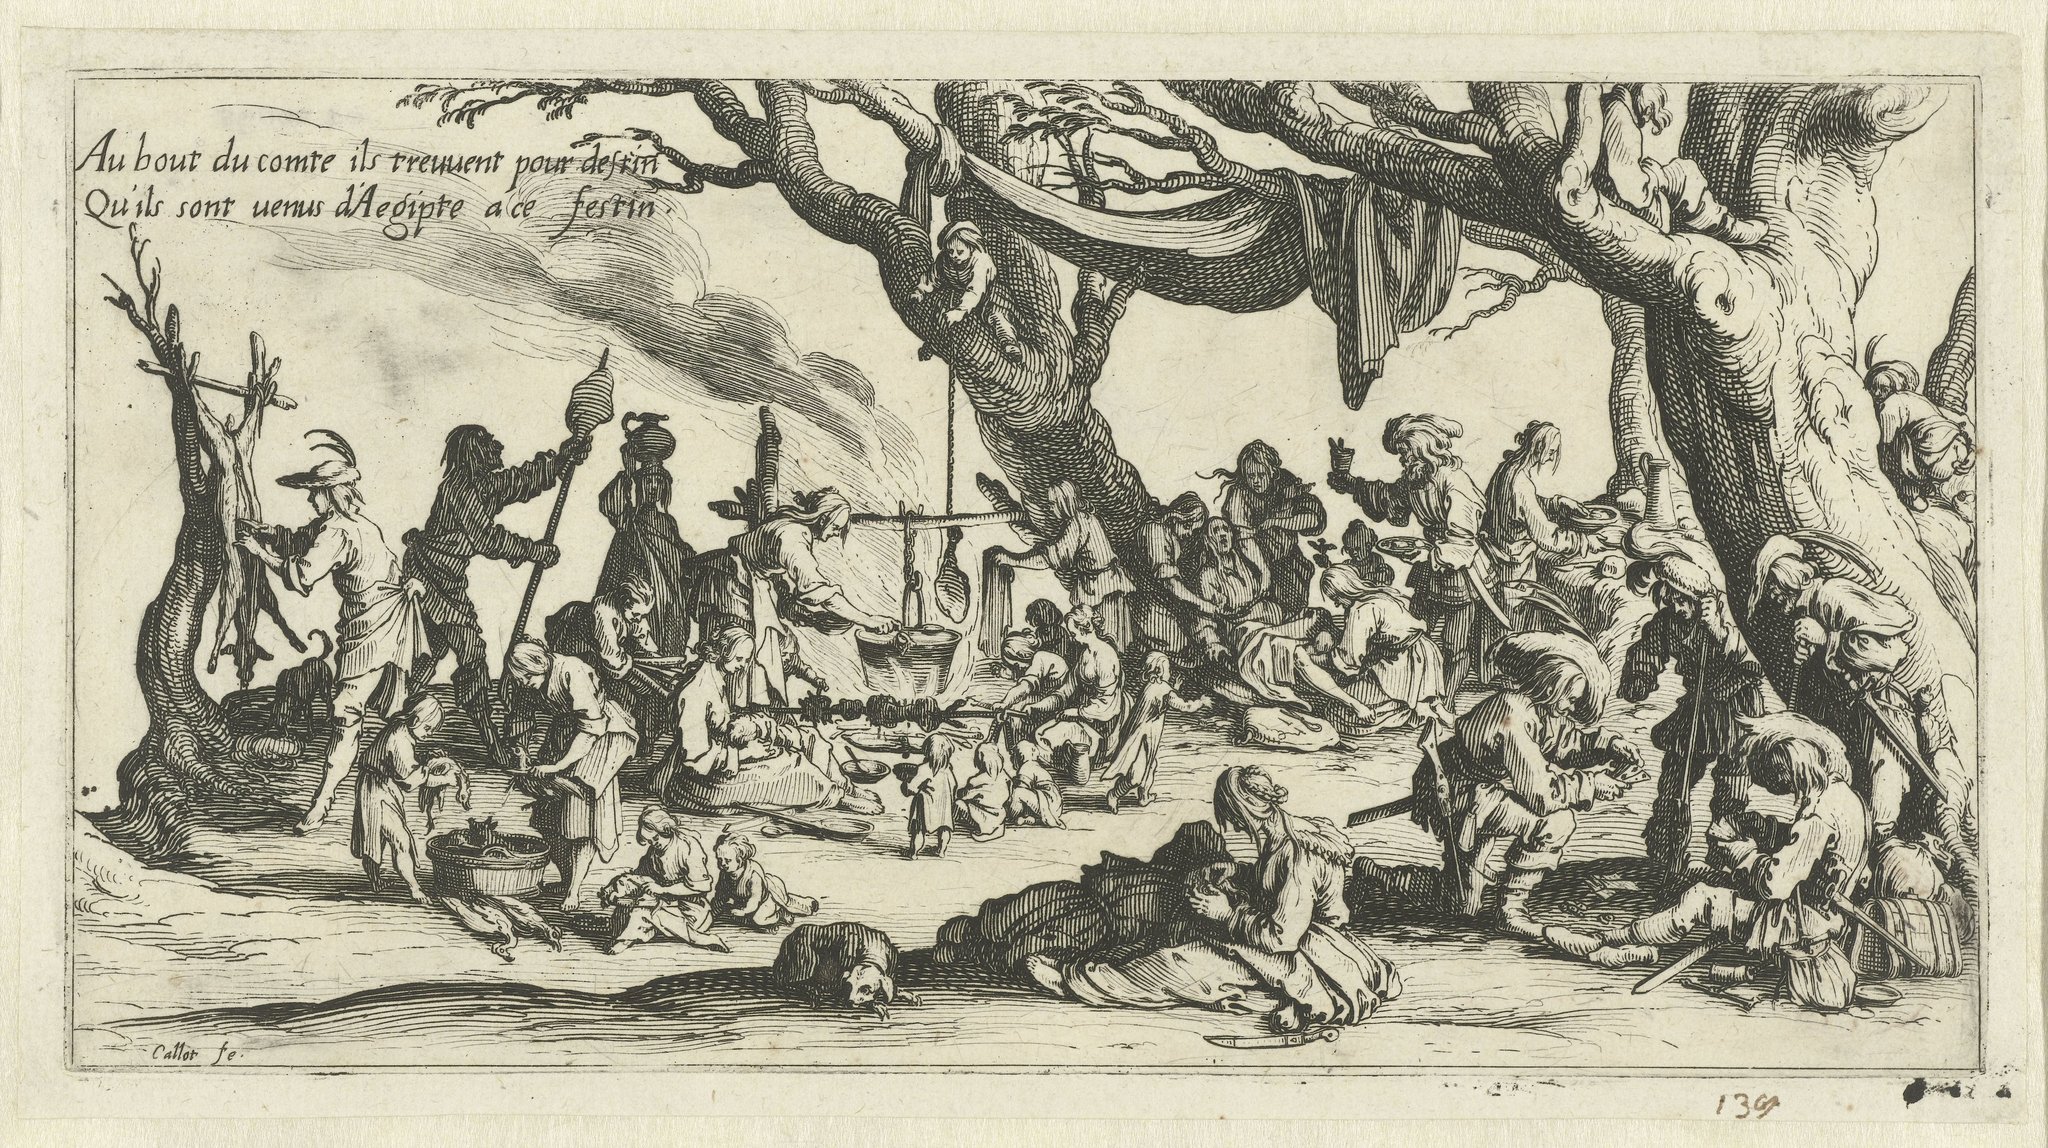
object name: print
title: Roma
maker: jacques callot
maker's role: draughtsman, print maker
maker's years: 1592-1635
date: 1621-1631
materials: paper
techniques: engraving, etching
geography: nancy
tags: wandering communities: romani or roma, woman giving birth (lying-in), cooking food - cc - in the open air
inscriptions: collector's mark: Lugt 240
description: Een groep zigeuners heeft zijn kamp opgeslagen tussen een aantal bomen. Links en in het midden bereiden enkelen van hen een maaltijd. Rechts op de voorgrond spelen een aantal mannen een kaartspel. Rechts op de achtergrond brengt een vrouw een kind ter wereld. Bovenin de voorstelling twee regels Franse tekst. Deze prent is onderdeel van een serie van vier prenten met voorstellingen van het leven van zigeuners.